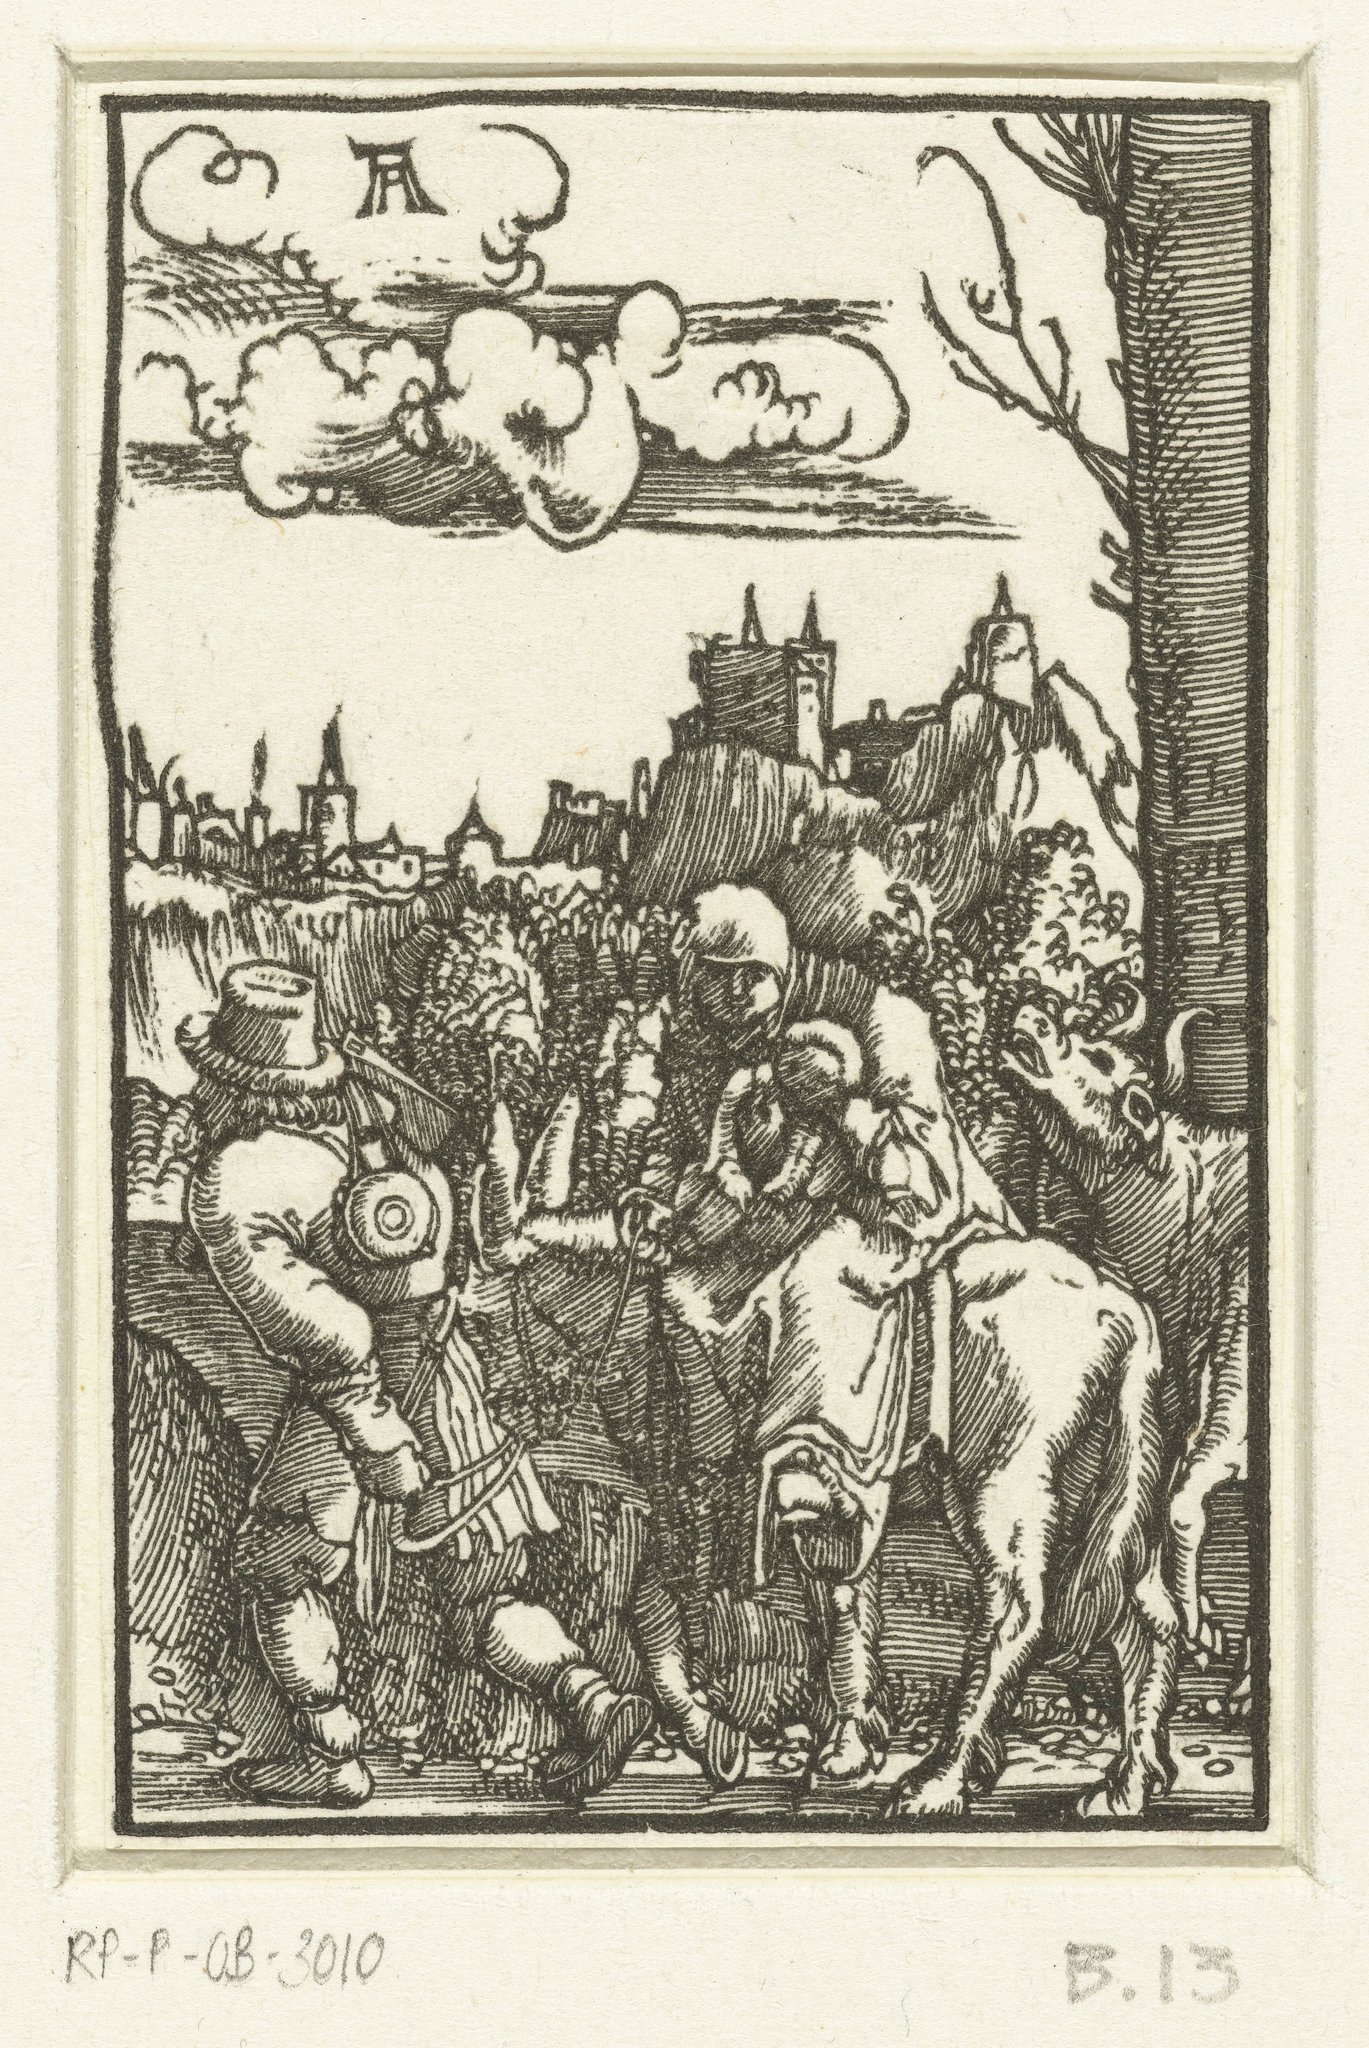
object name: print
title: De val en verlossing van de mensheid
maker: albrecht altdorfer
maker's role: draughtsman, print maker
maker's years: 1480-1538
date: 1506-1538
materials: paper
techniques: woodcut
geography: germany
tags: the flight into egypt: mary, joseph, the child (and sometimes others) on their way; mary usually riding on an ass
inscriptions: number: ‘58’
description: Jozef, op de rug gezien, leidt de ezel waarop Maria met het Christuskind zit. Dertiende prent uit een serie van veertig.